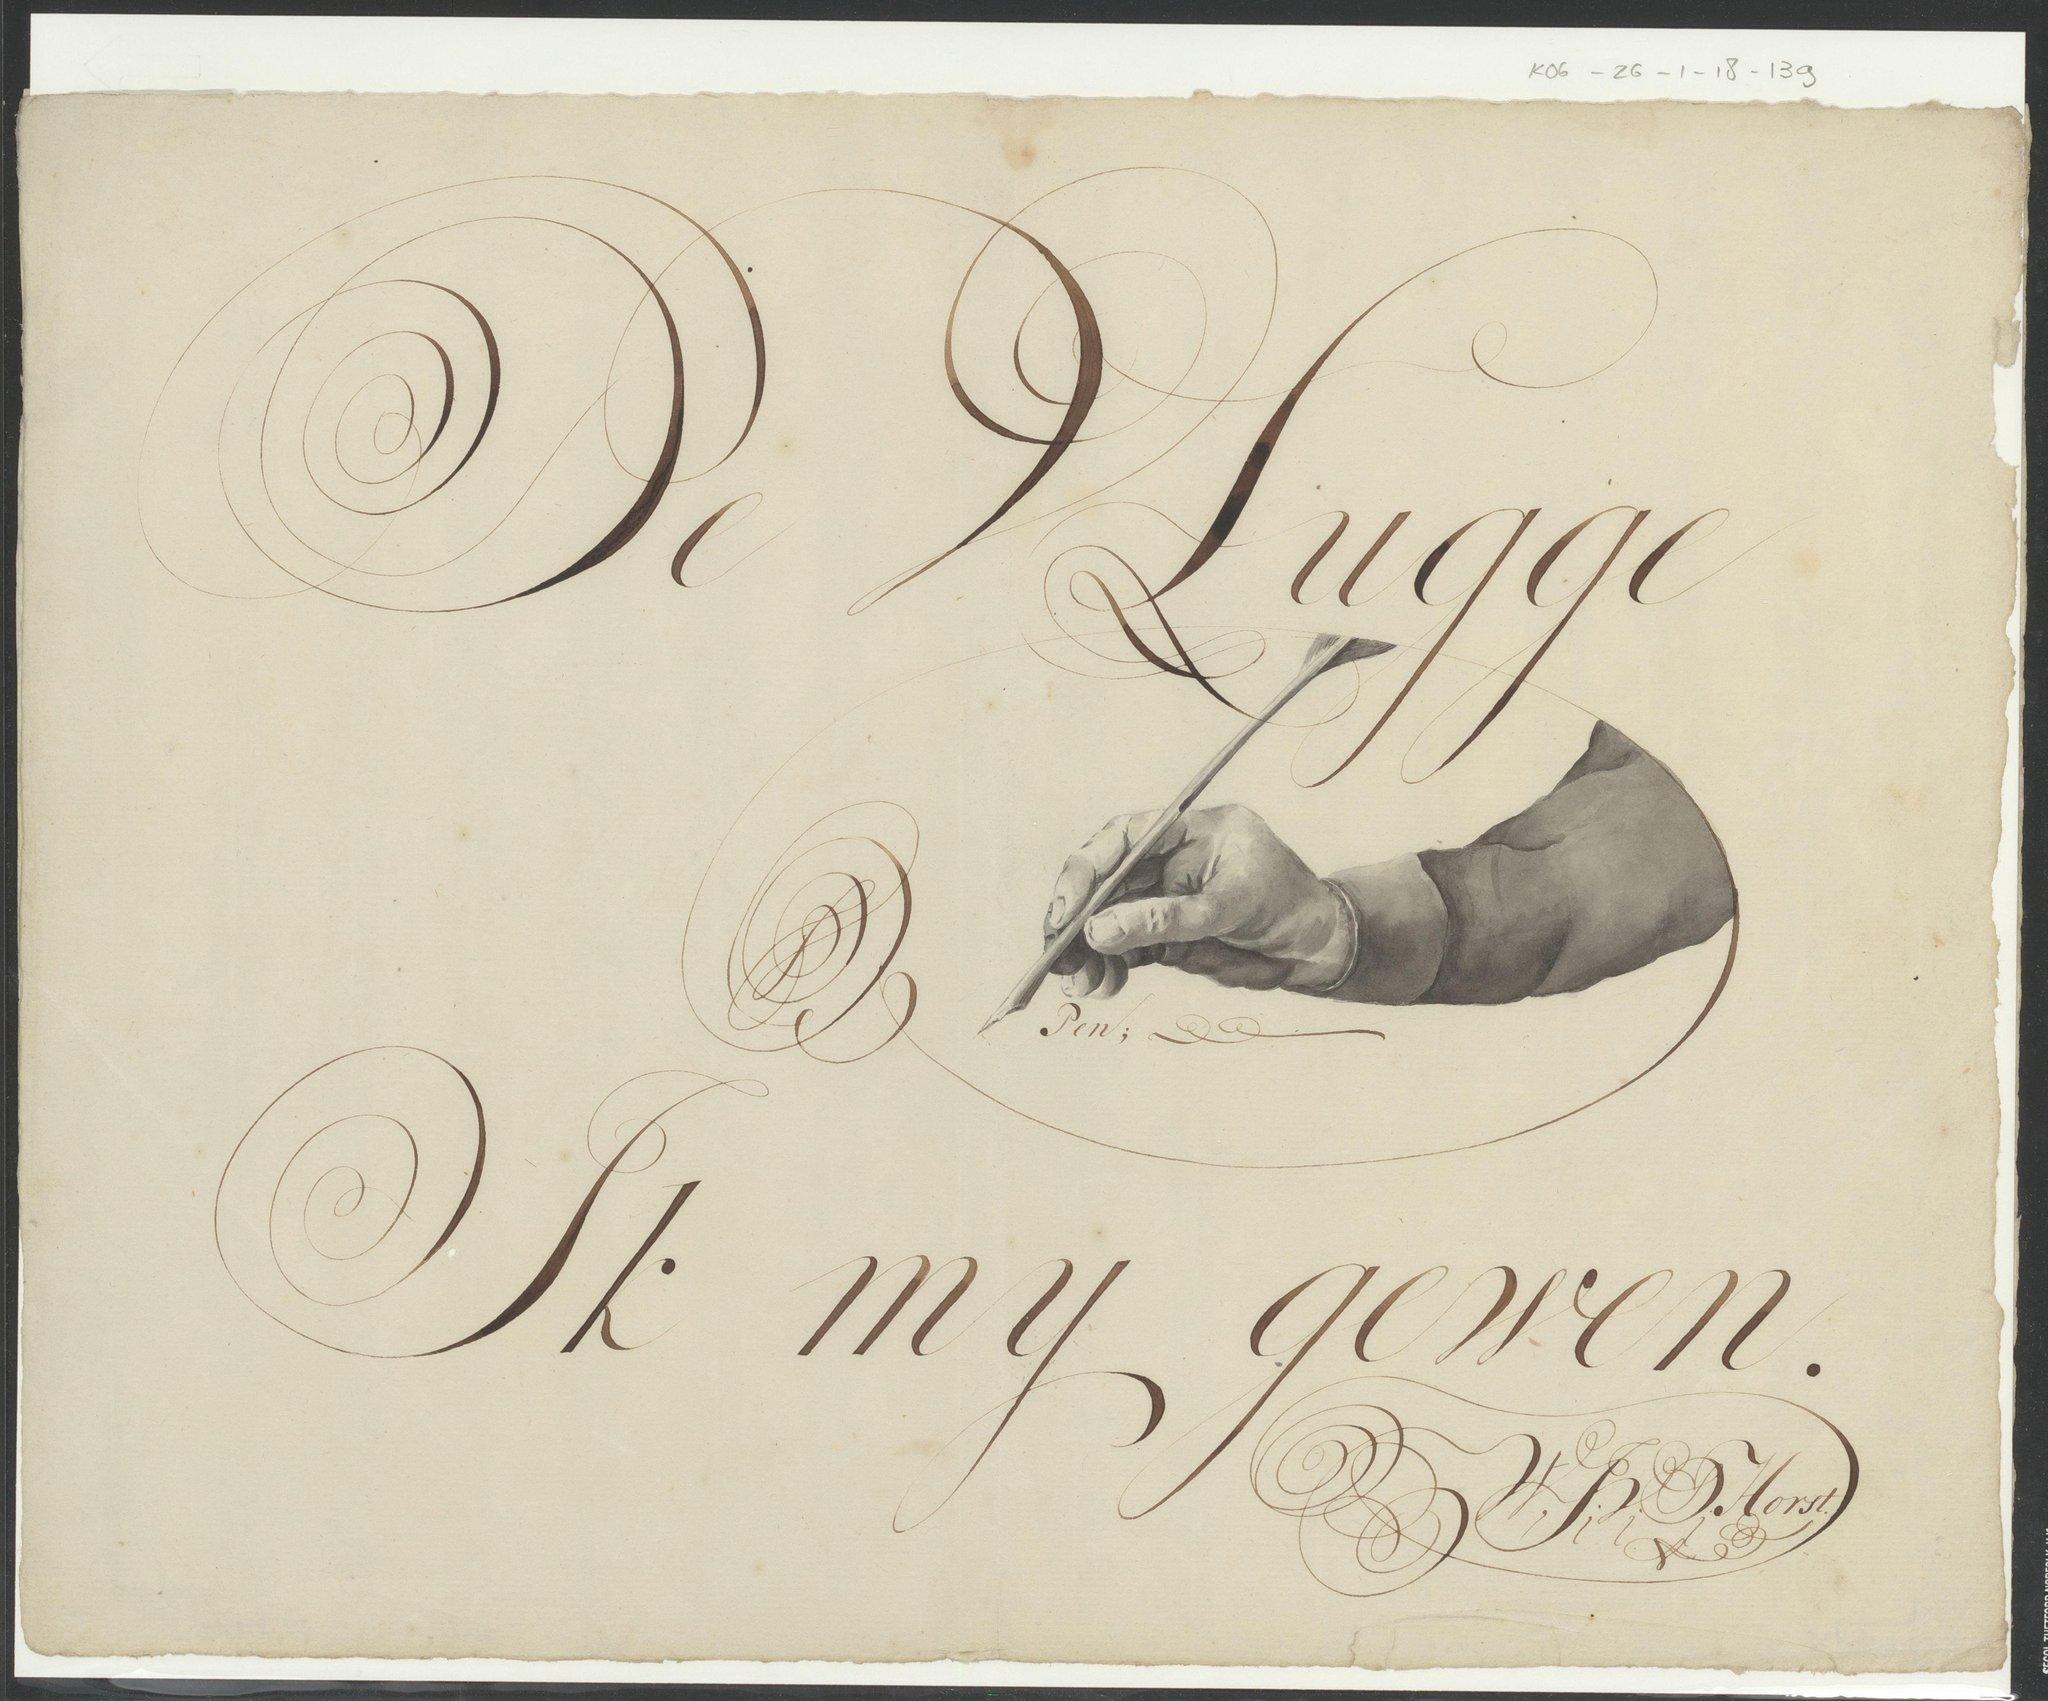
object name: calligraphy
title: Kalligrafie op De vlugge Pen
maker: w.b.d. horst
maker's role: kalligraaf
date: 1800-1849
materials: ink, paper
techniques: brush, pen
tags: handwriting, writing as activity, quill, calligraphy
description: Kalligrafie met de tekst: De Vlugge Pen; Ik mij gewen. In het midden een hand die schrijft met een ganzenveer. Onderwerpsrubrieken binnen de Atlas Zeden en Gewoonten: Schoone kunsten, Pennekunst.